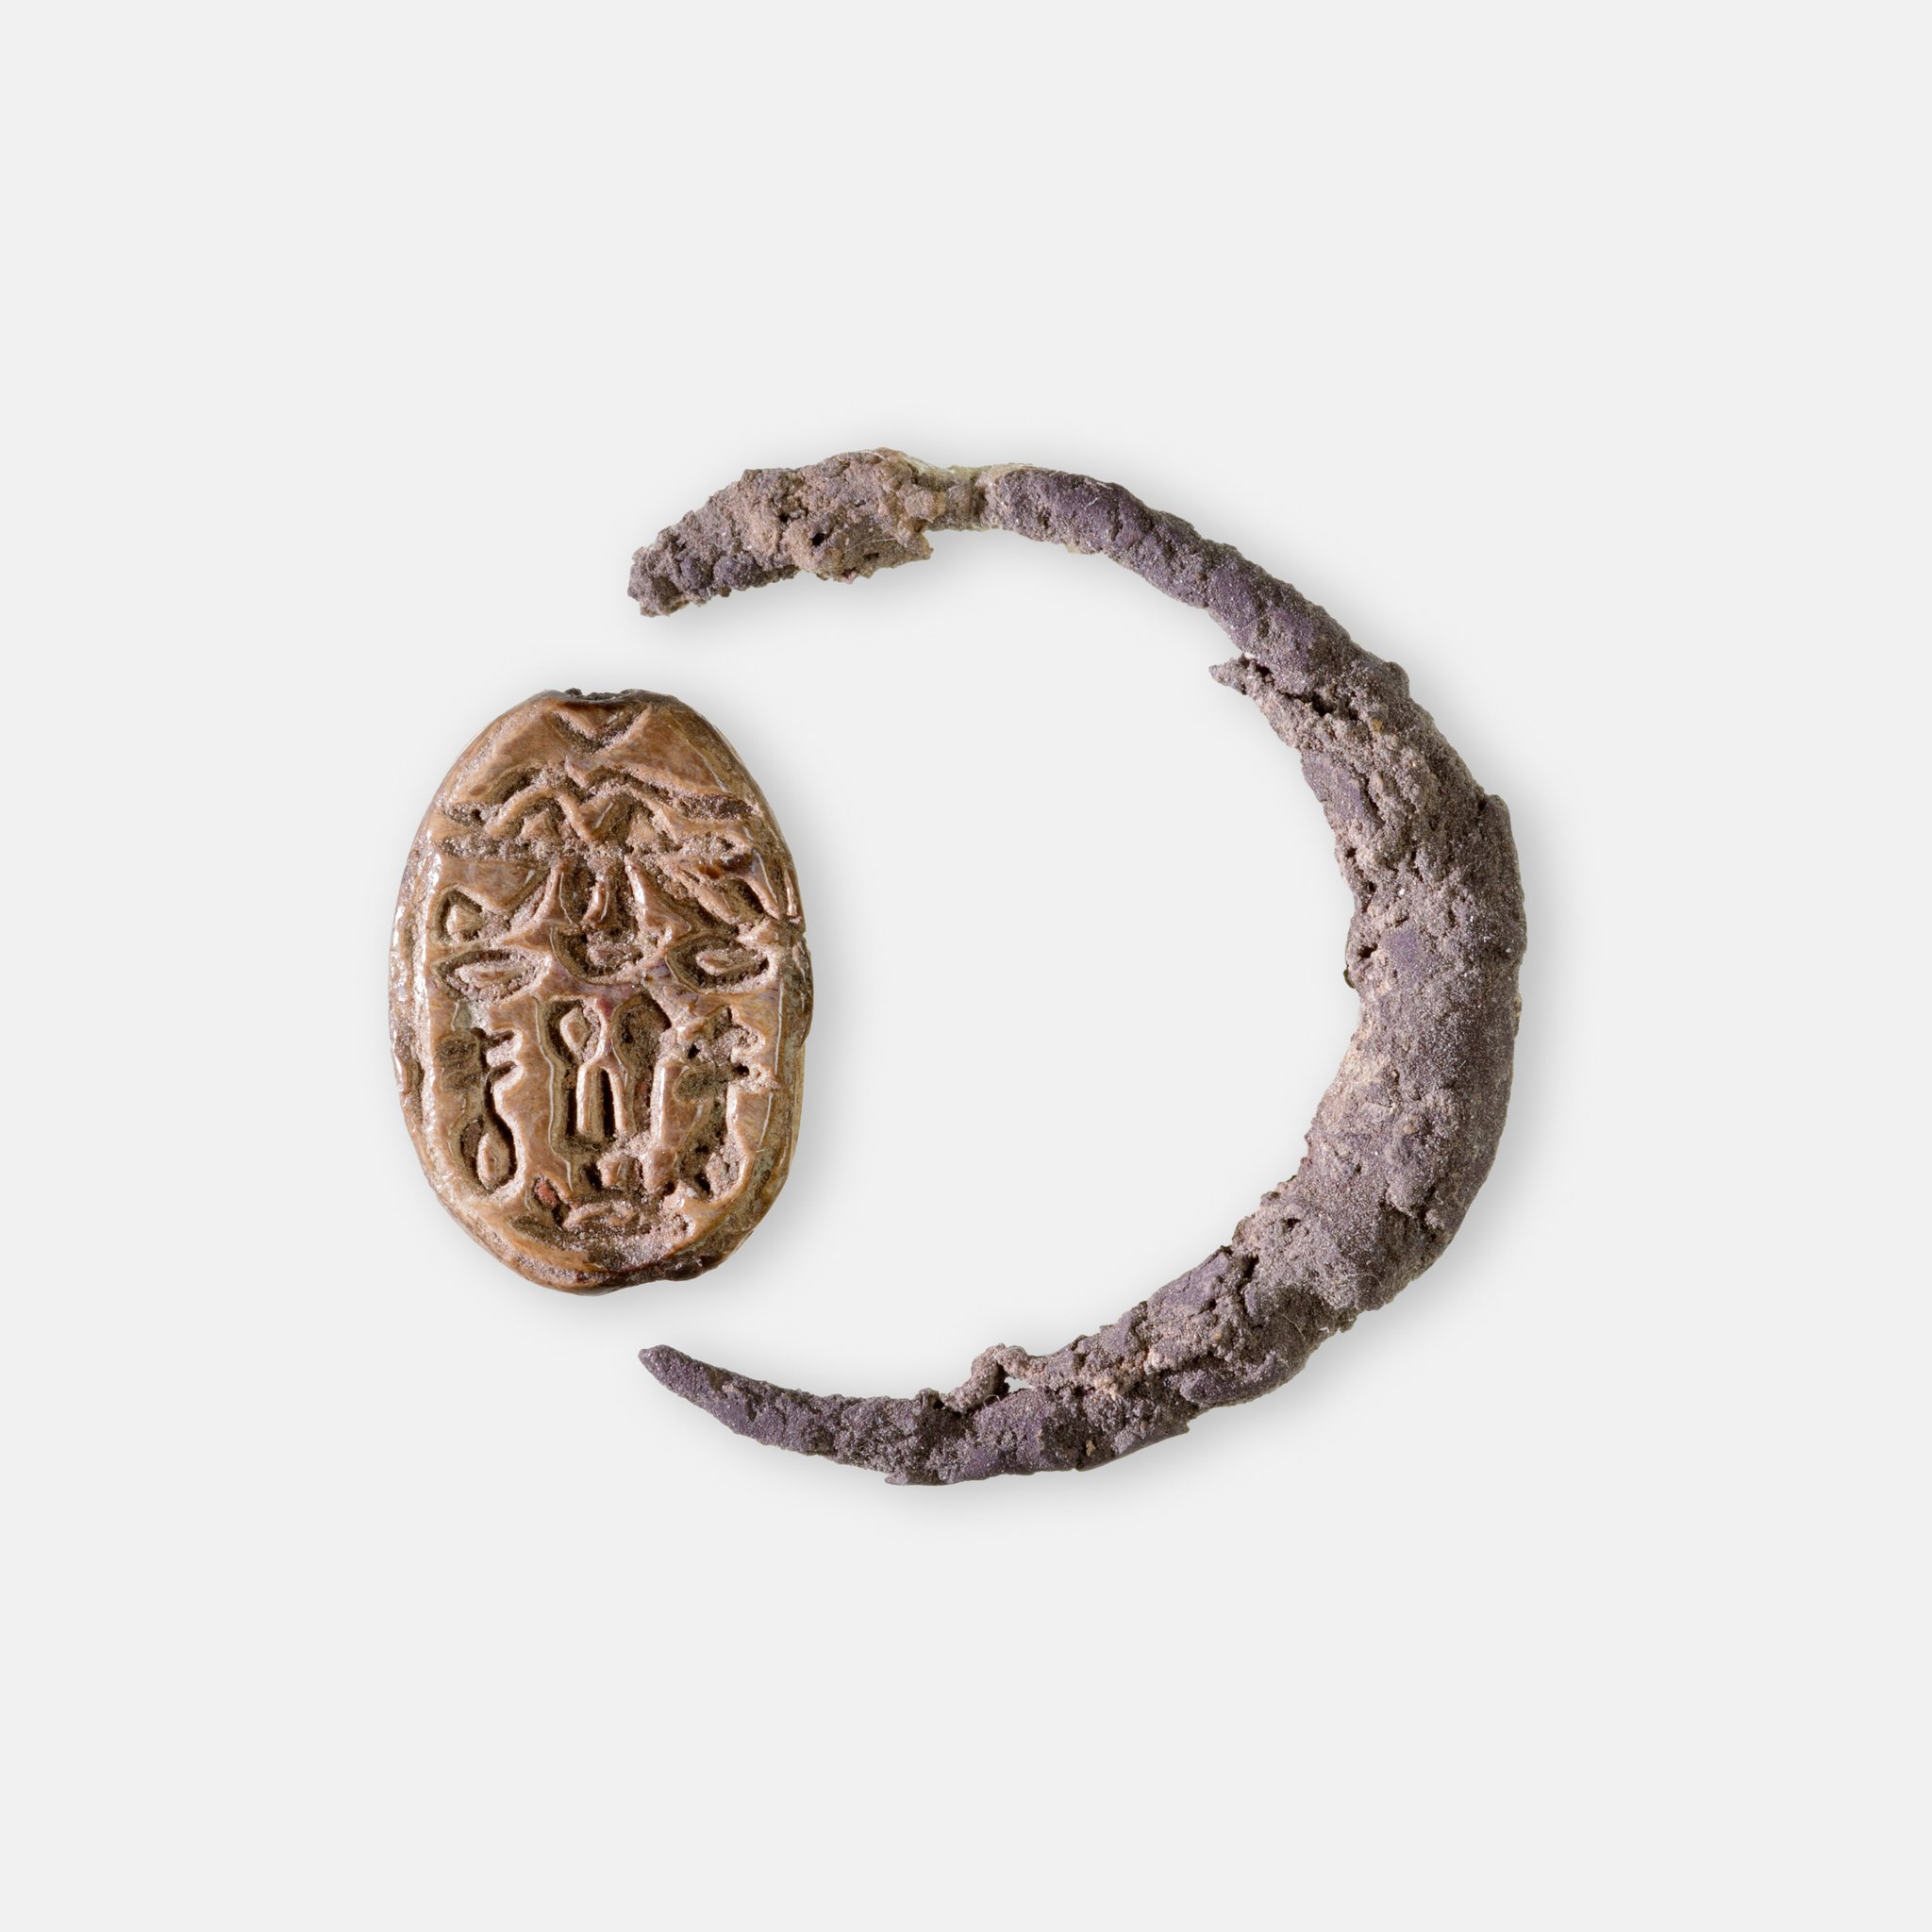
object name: ring, ruiu, scarab, hieroglyph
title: Scarab Ring of Ruiu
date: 1504-1447 BCE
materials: silver, stone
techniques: glazing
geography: egypt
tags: hieroglyphs,scarabs